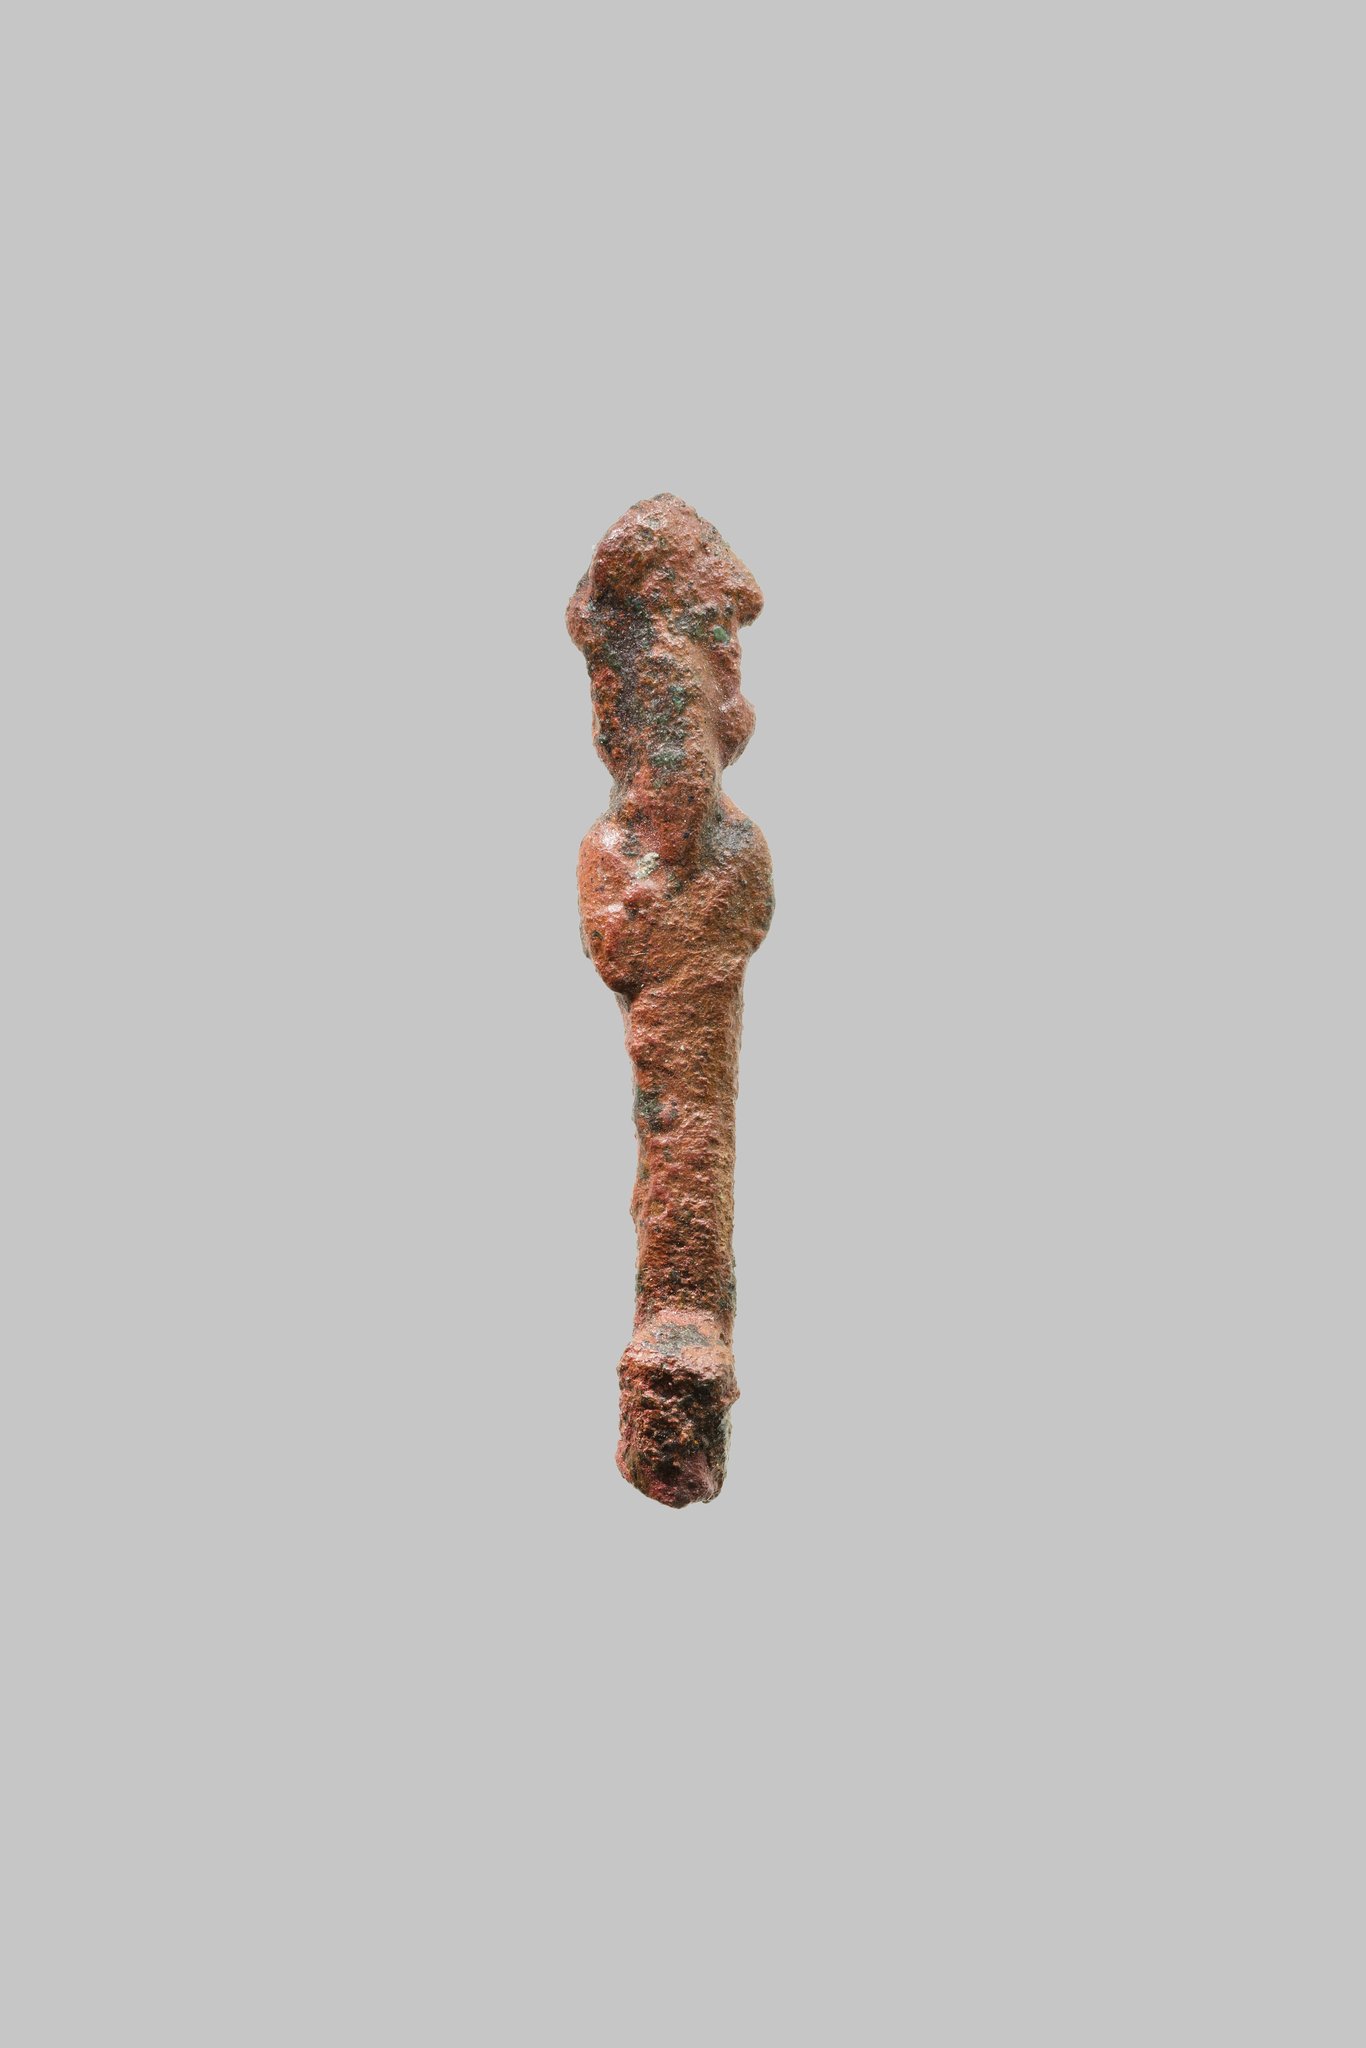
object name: statuette, osiris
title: Osiris Figure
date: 712-30 BCE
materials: bronze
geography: egypt